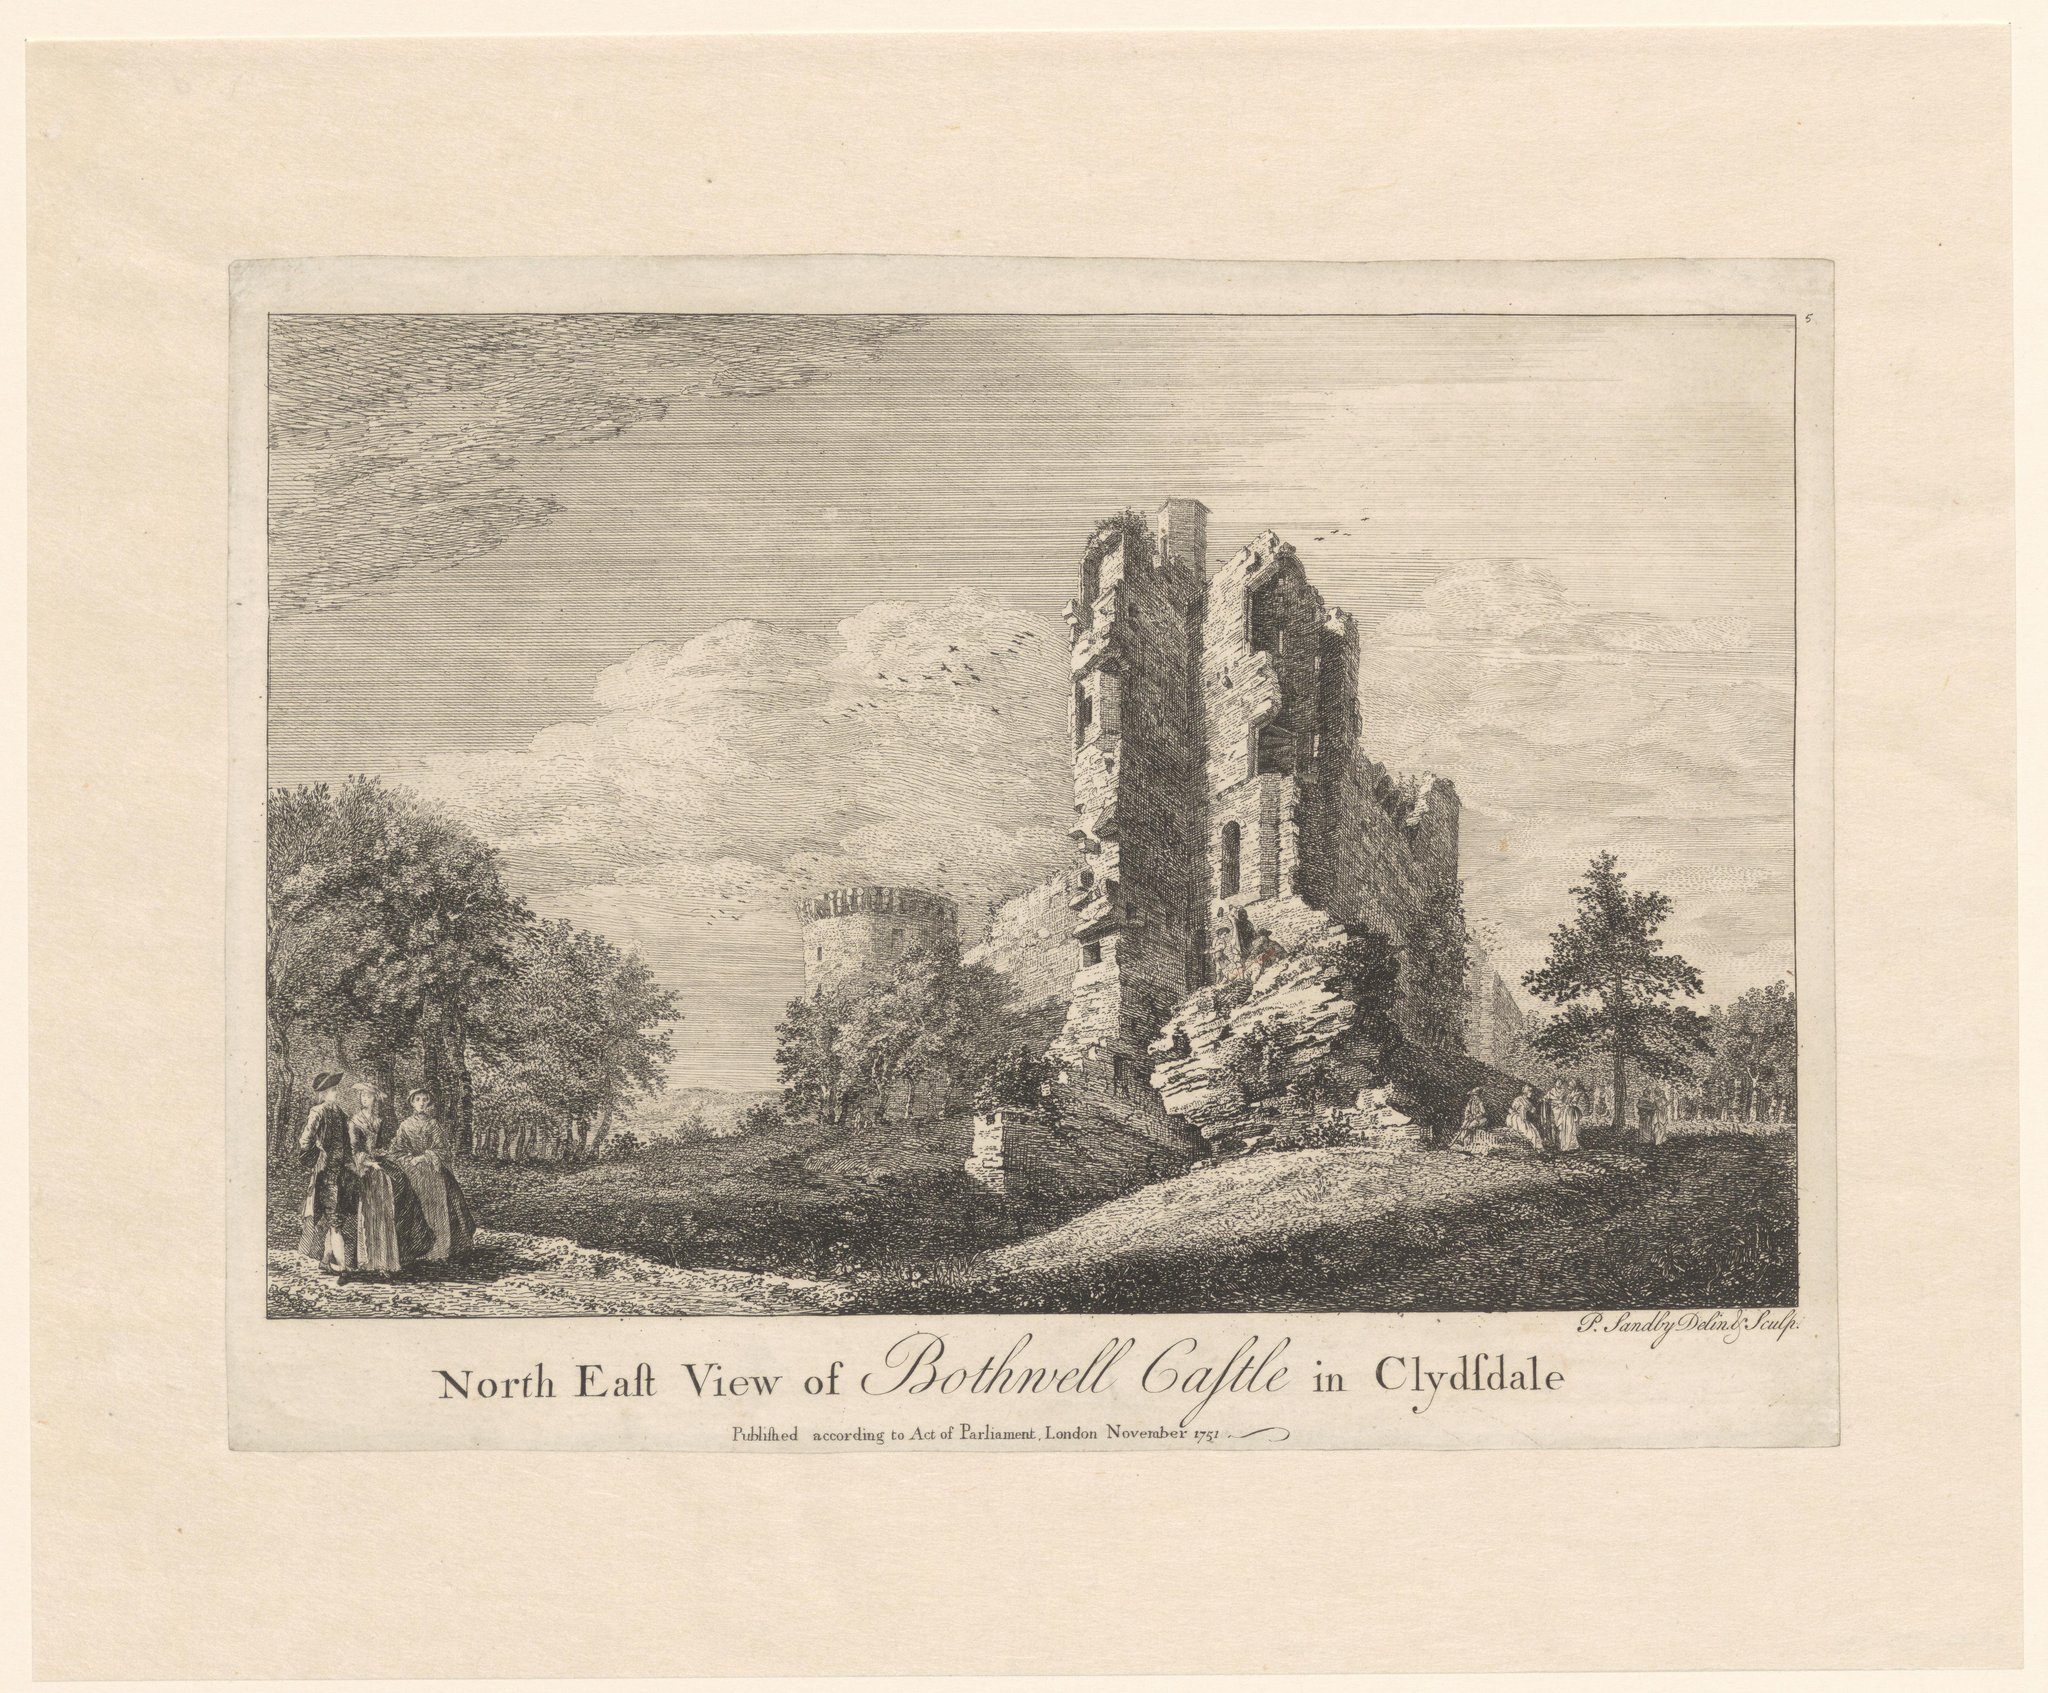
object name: print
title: Gezicht op de ruïne van Bothwell Castle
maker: paul sandby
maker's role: draughtsman, print maker, publisher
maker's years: 1725-1809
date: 1751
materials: paper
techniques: engraving, etching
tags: castle, dale, valley (+ landscape with figures, staffage)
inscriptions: collector's mark: Lugt 2760, collector's mark: Lugt 2228